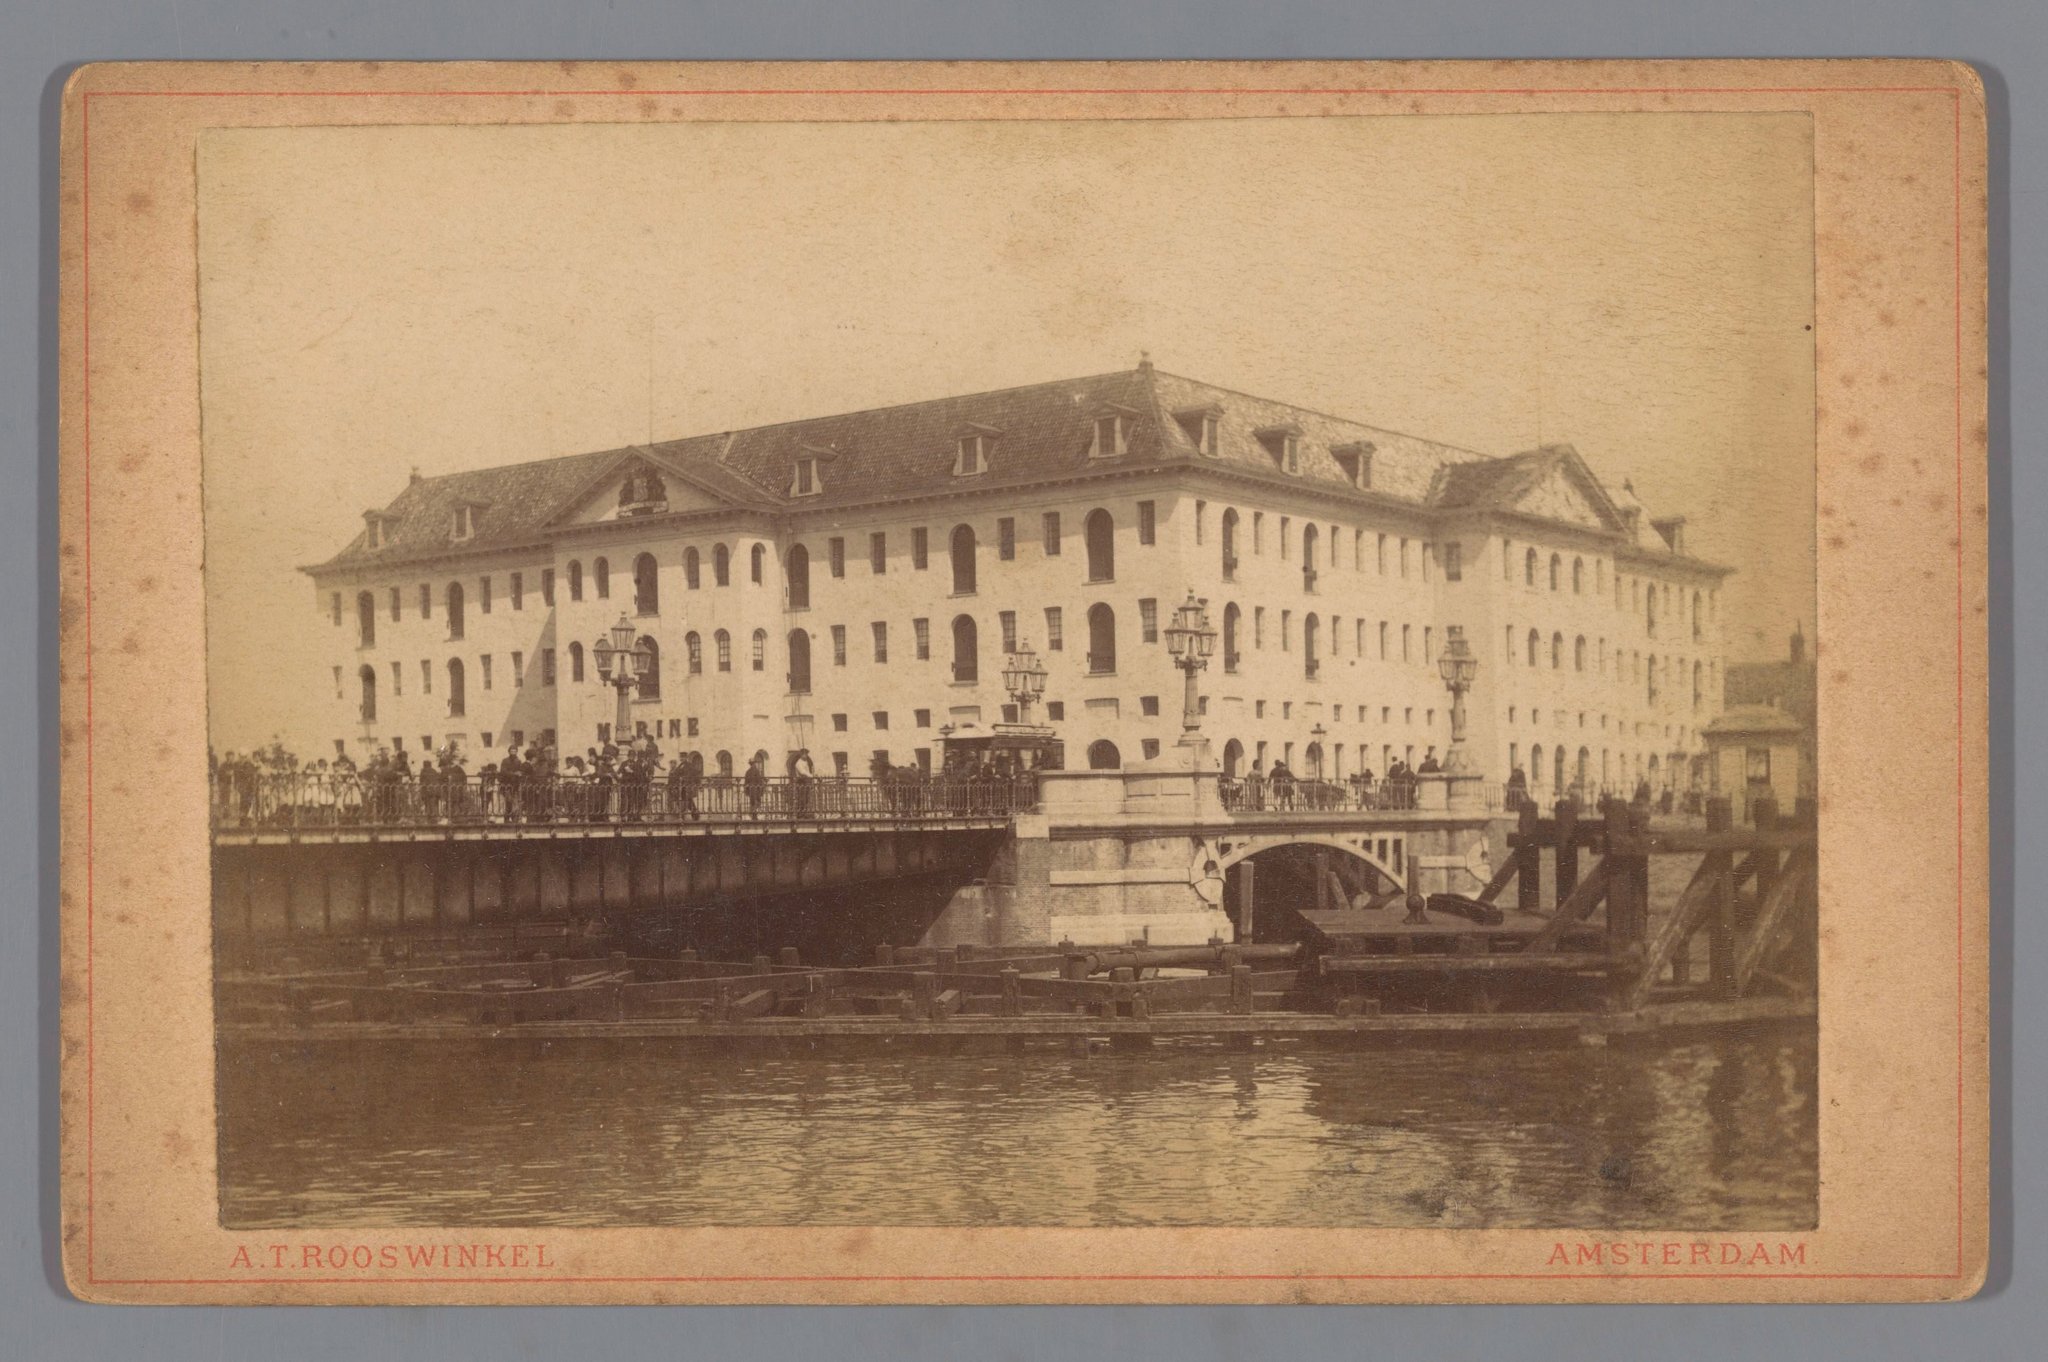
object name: photograph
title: Gezicht op 's Lands Zeemagazijn in Amsterdam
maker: andreas theodorus rooswinkel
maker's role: fotograaf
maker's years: 1838-1909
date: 1868-1900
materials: cardboard, photographic support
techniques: albumen print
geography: amsterdam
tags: large-scale structure for storage, e.g.: warehouse, depot, silo, navy